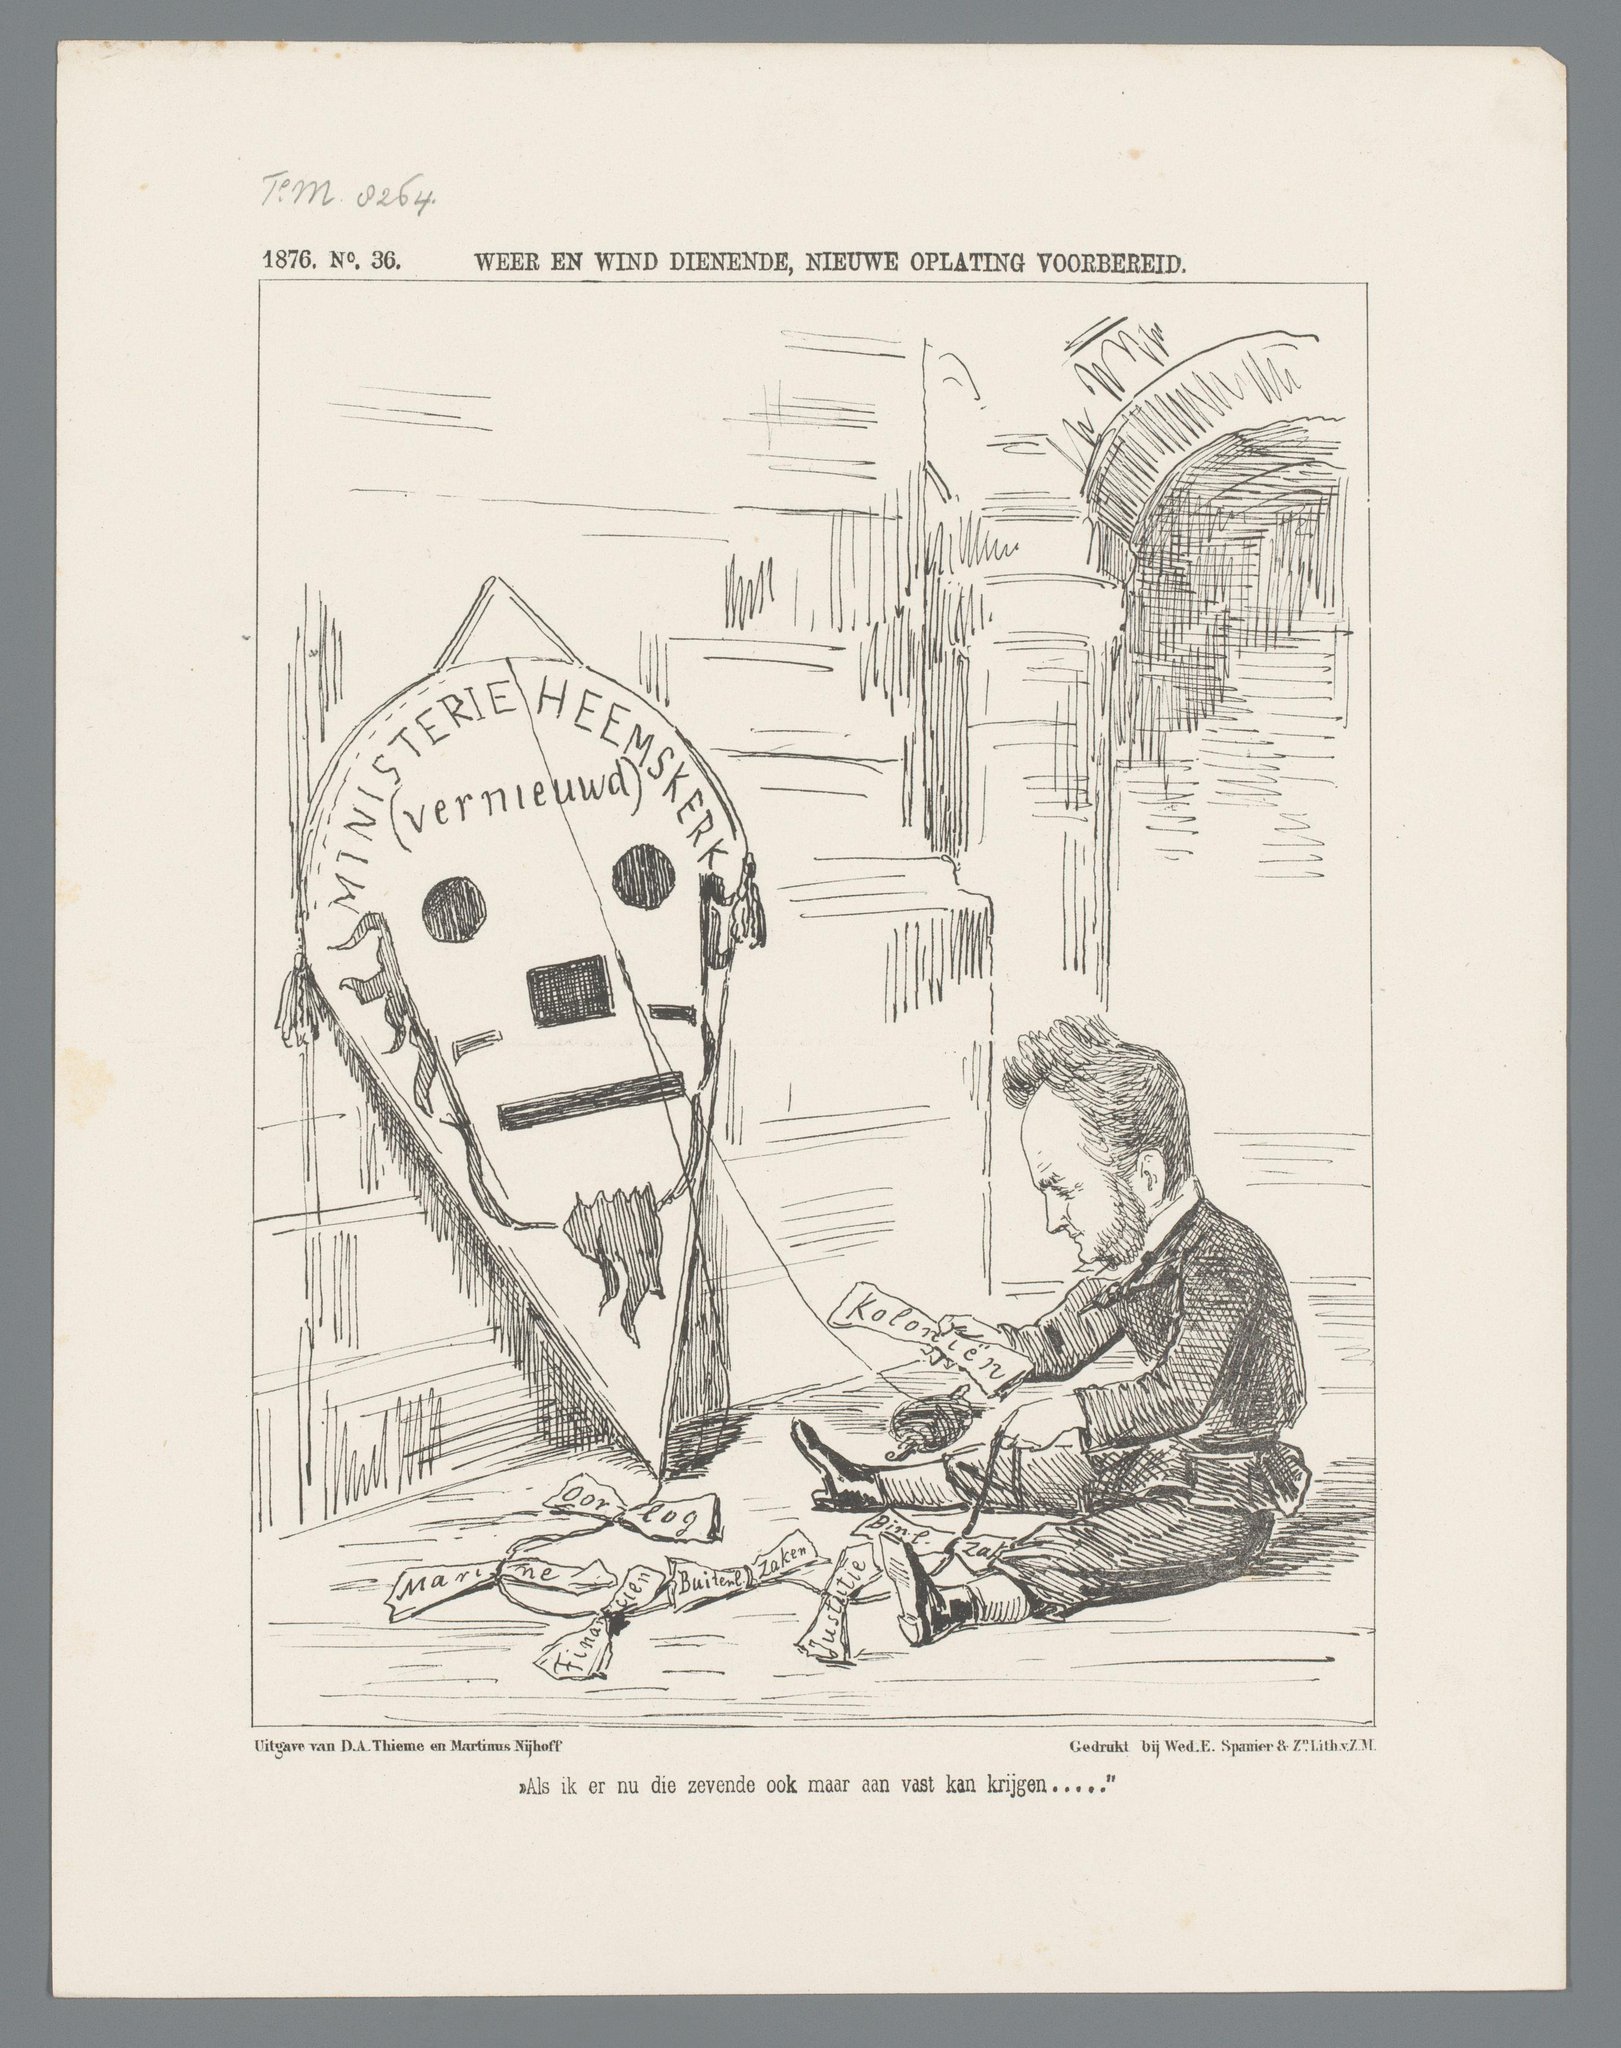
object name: cartoon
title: Weer en wind dienende, nieuwe oplating voorbereid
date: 1876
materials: paper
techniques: lithograph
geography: netherlands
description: Spotprent . Plaat verschenen bij het weekblad De Nederlandsche Spectator, nr. 36, 1876.